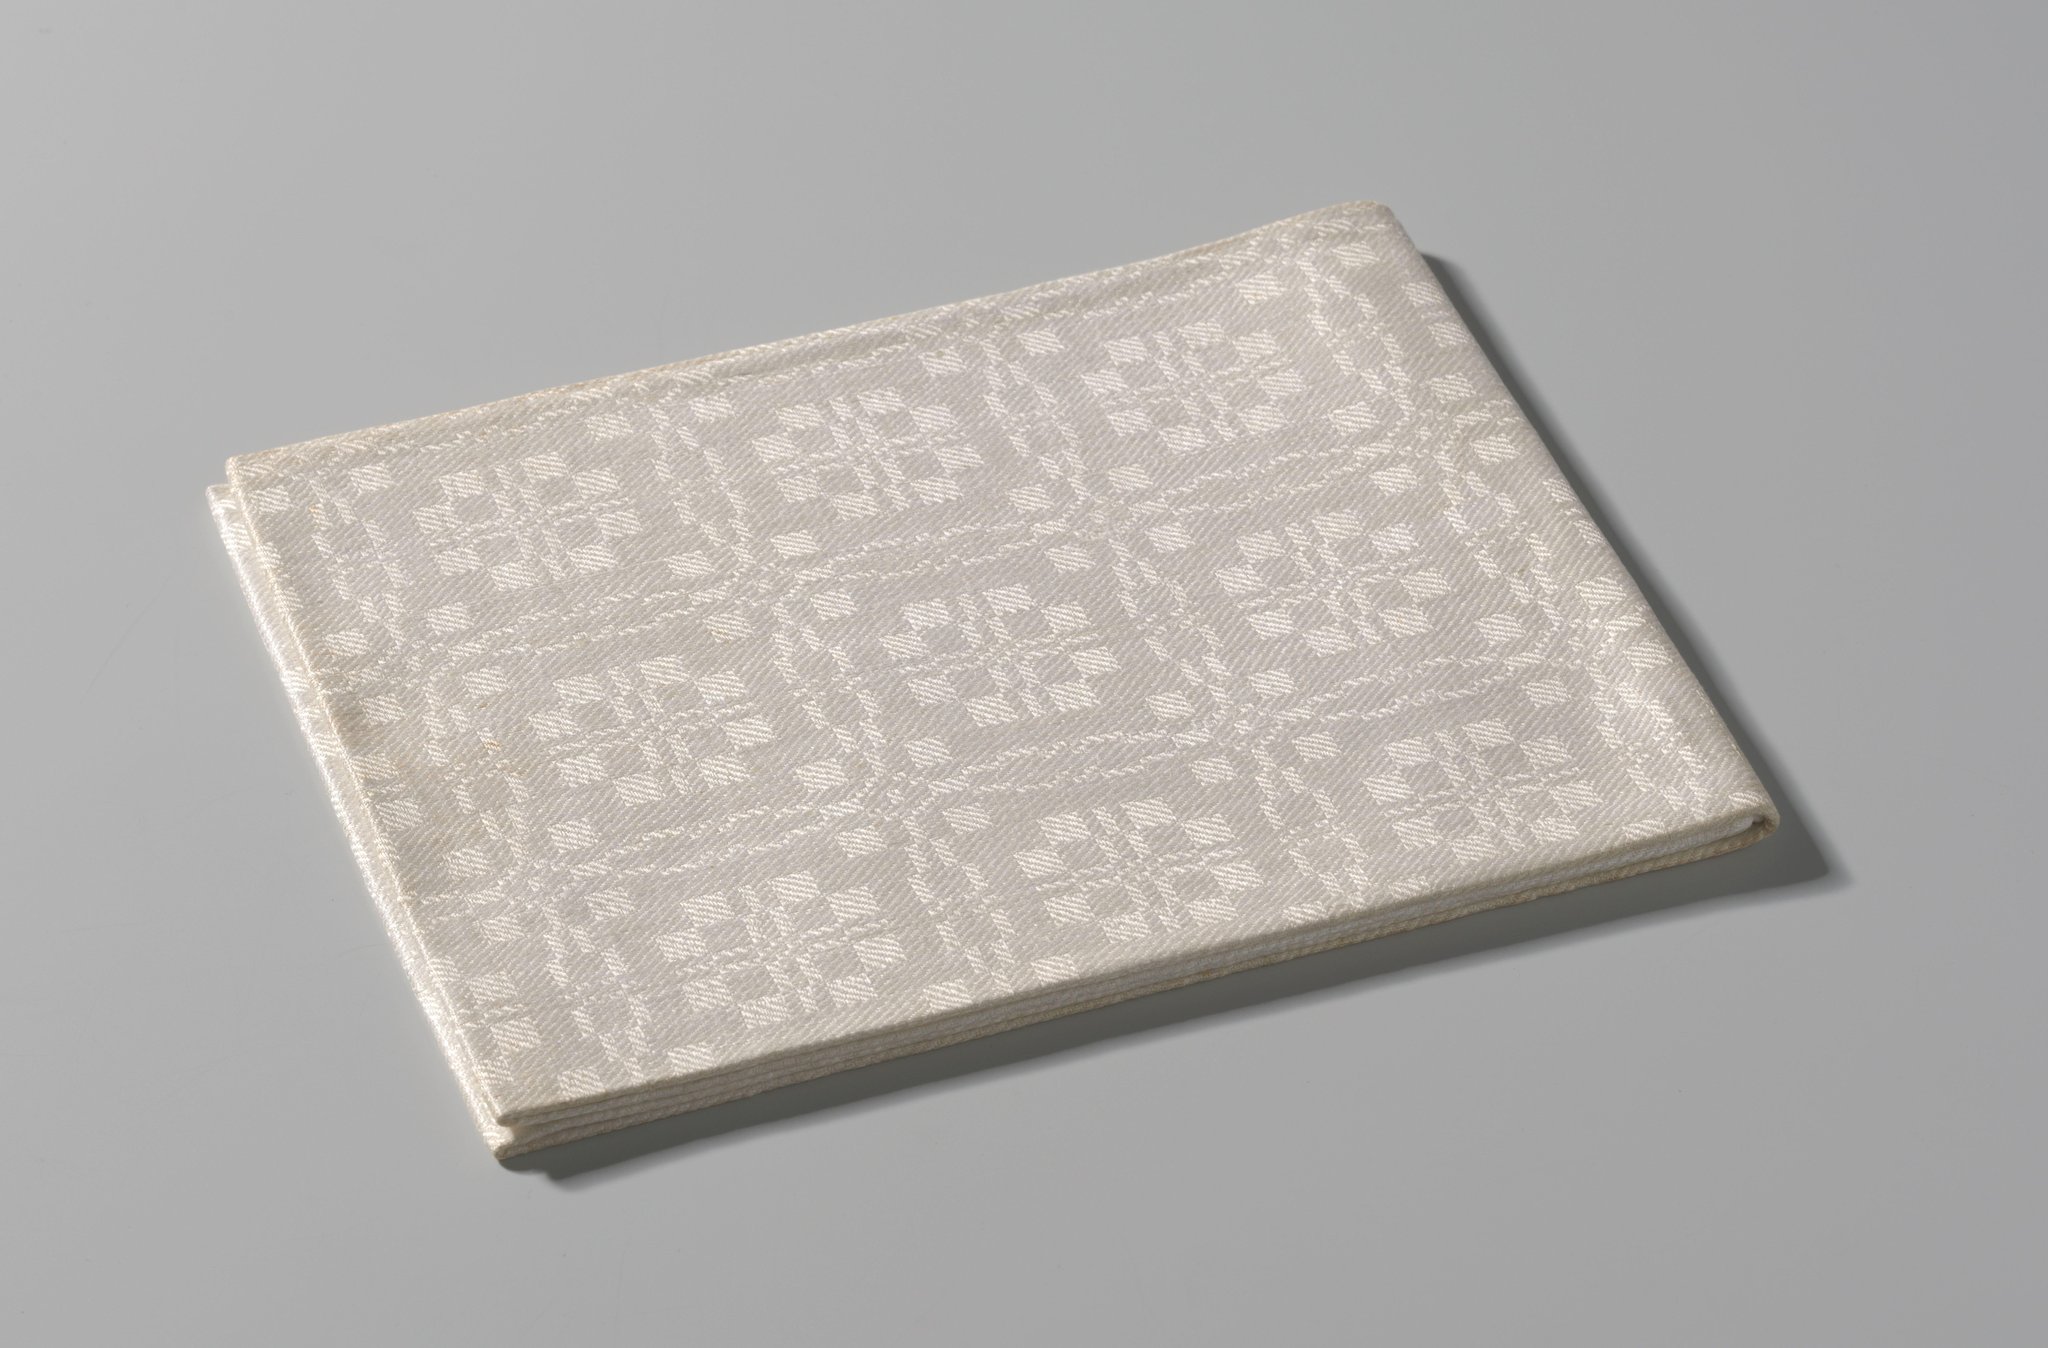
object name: napkin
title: Servet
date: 1752-1783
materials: linen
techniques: twill, peeled fabric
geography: northern netherlands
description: Wit linnen servet met pellen patroon, merk kroon H 21 en P.